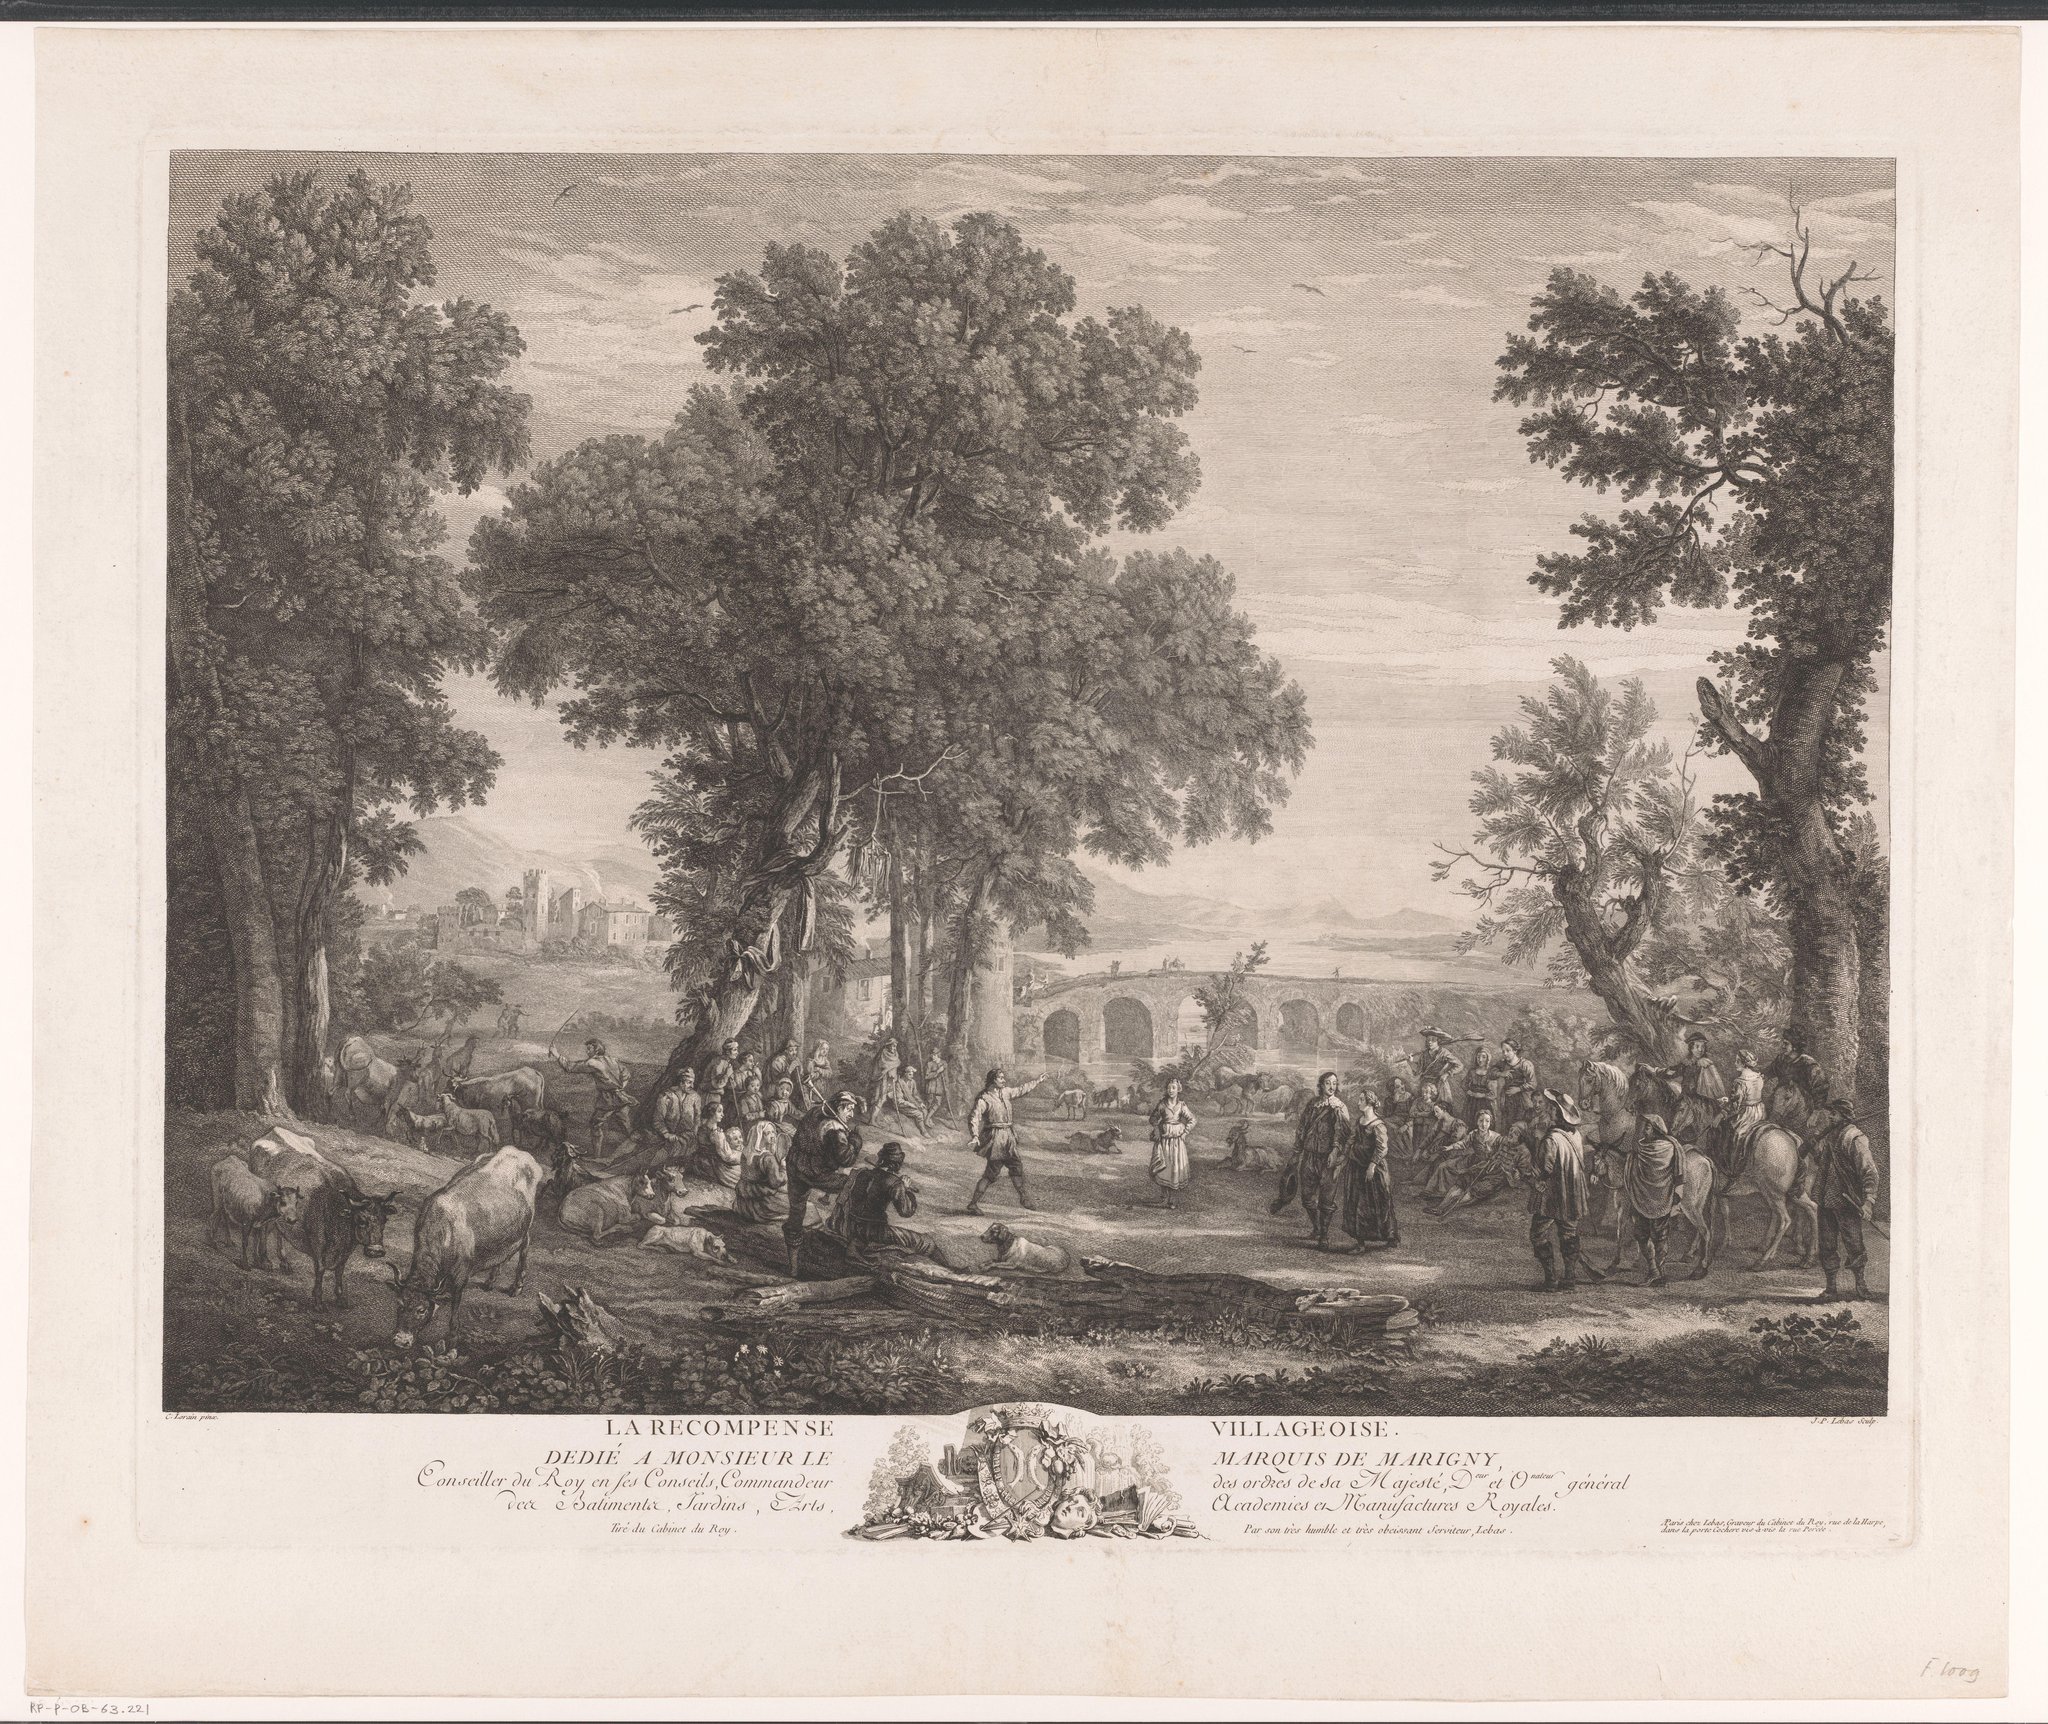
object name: print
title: La Recompense Villageoise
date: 1717-1783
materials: paper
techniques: engraving, etching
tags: landscape with bridge, viaduct or aqueduct, group dancing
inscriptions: collector's mark: Lugt 240, inscription: ‘f 2100 a f 6-’